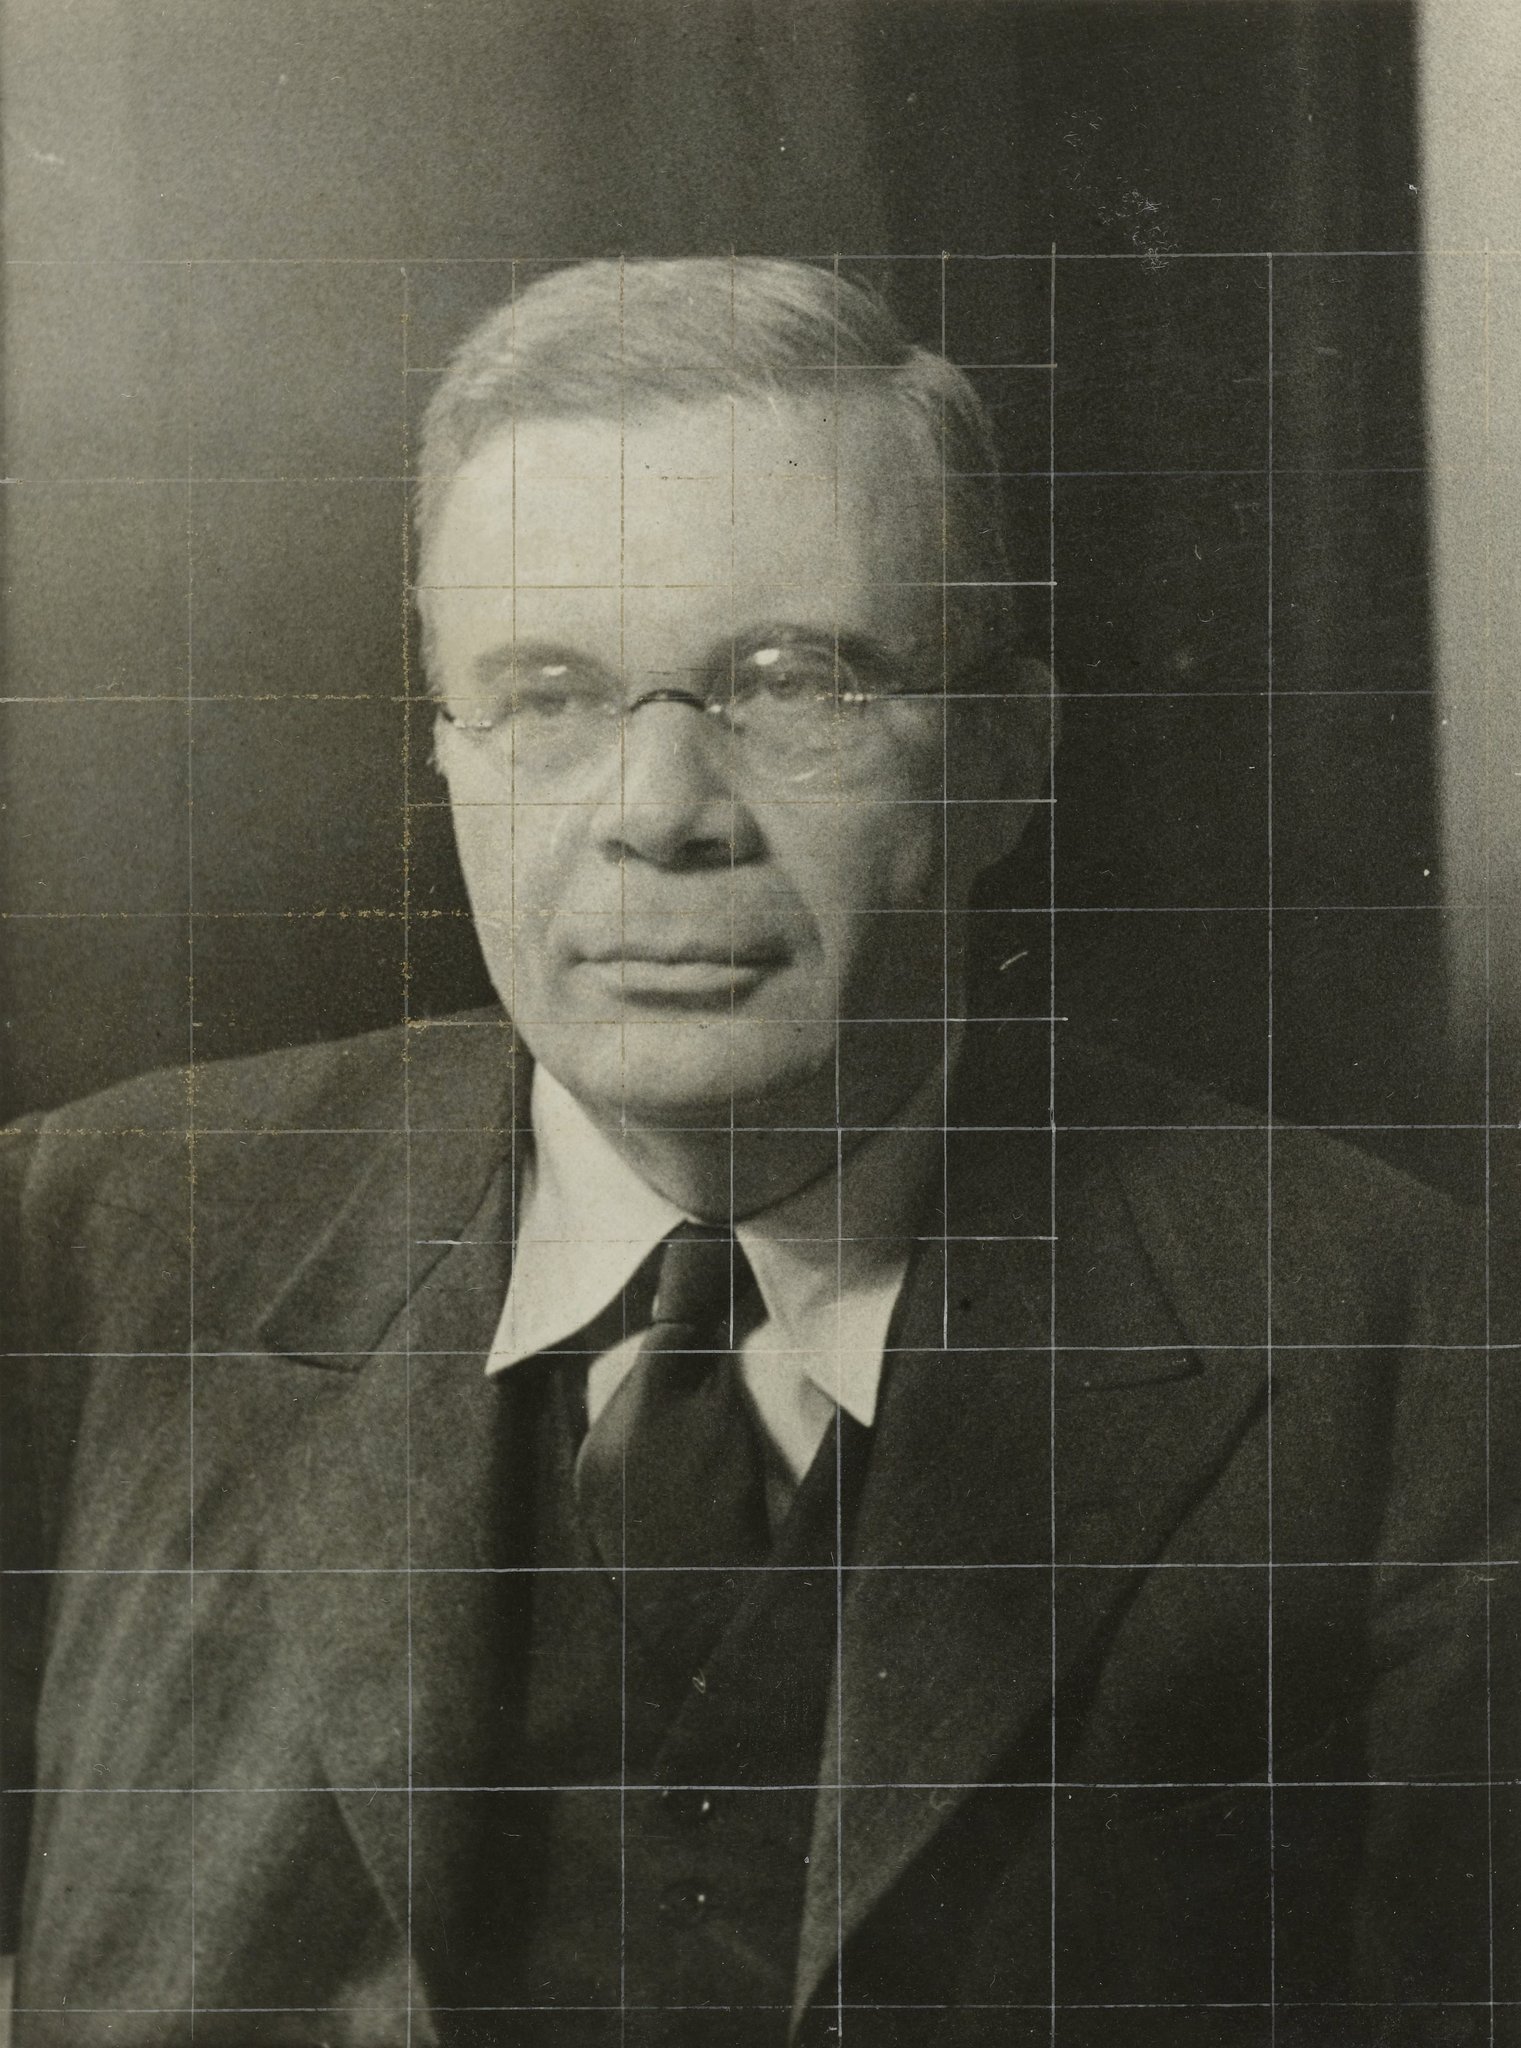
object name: photograph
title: Portret van Hubertus Johannes van Mook, minister van koloniën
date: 1940-1945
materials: photographic support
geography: london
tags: france, hubertus johannes van mook, london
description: Portret van Hubertus Johannes van Mook (1894-1965), minister van koloniën. Na de Japanse inval vluchtte Van Mook uit Nederlands-Indië naar Australië en ging van daar naar Londen. In Londen werd hij de Nederlandse minister van Koloniën. Het lijnennet op de foto is aangebracht door kunstenaar Cor Visser. Op de achterkant van de foto staan aantekeningen met potlood.